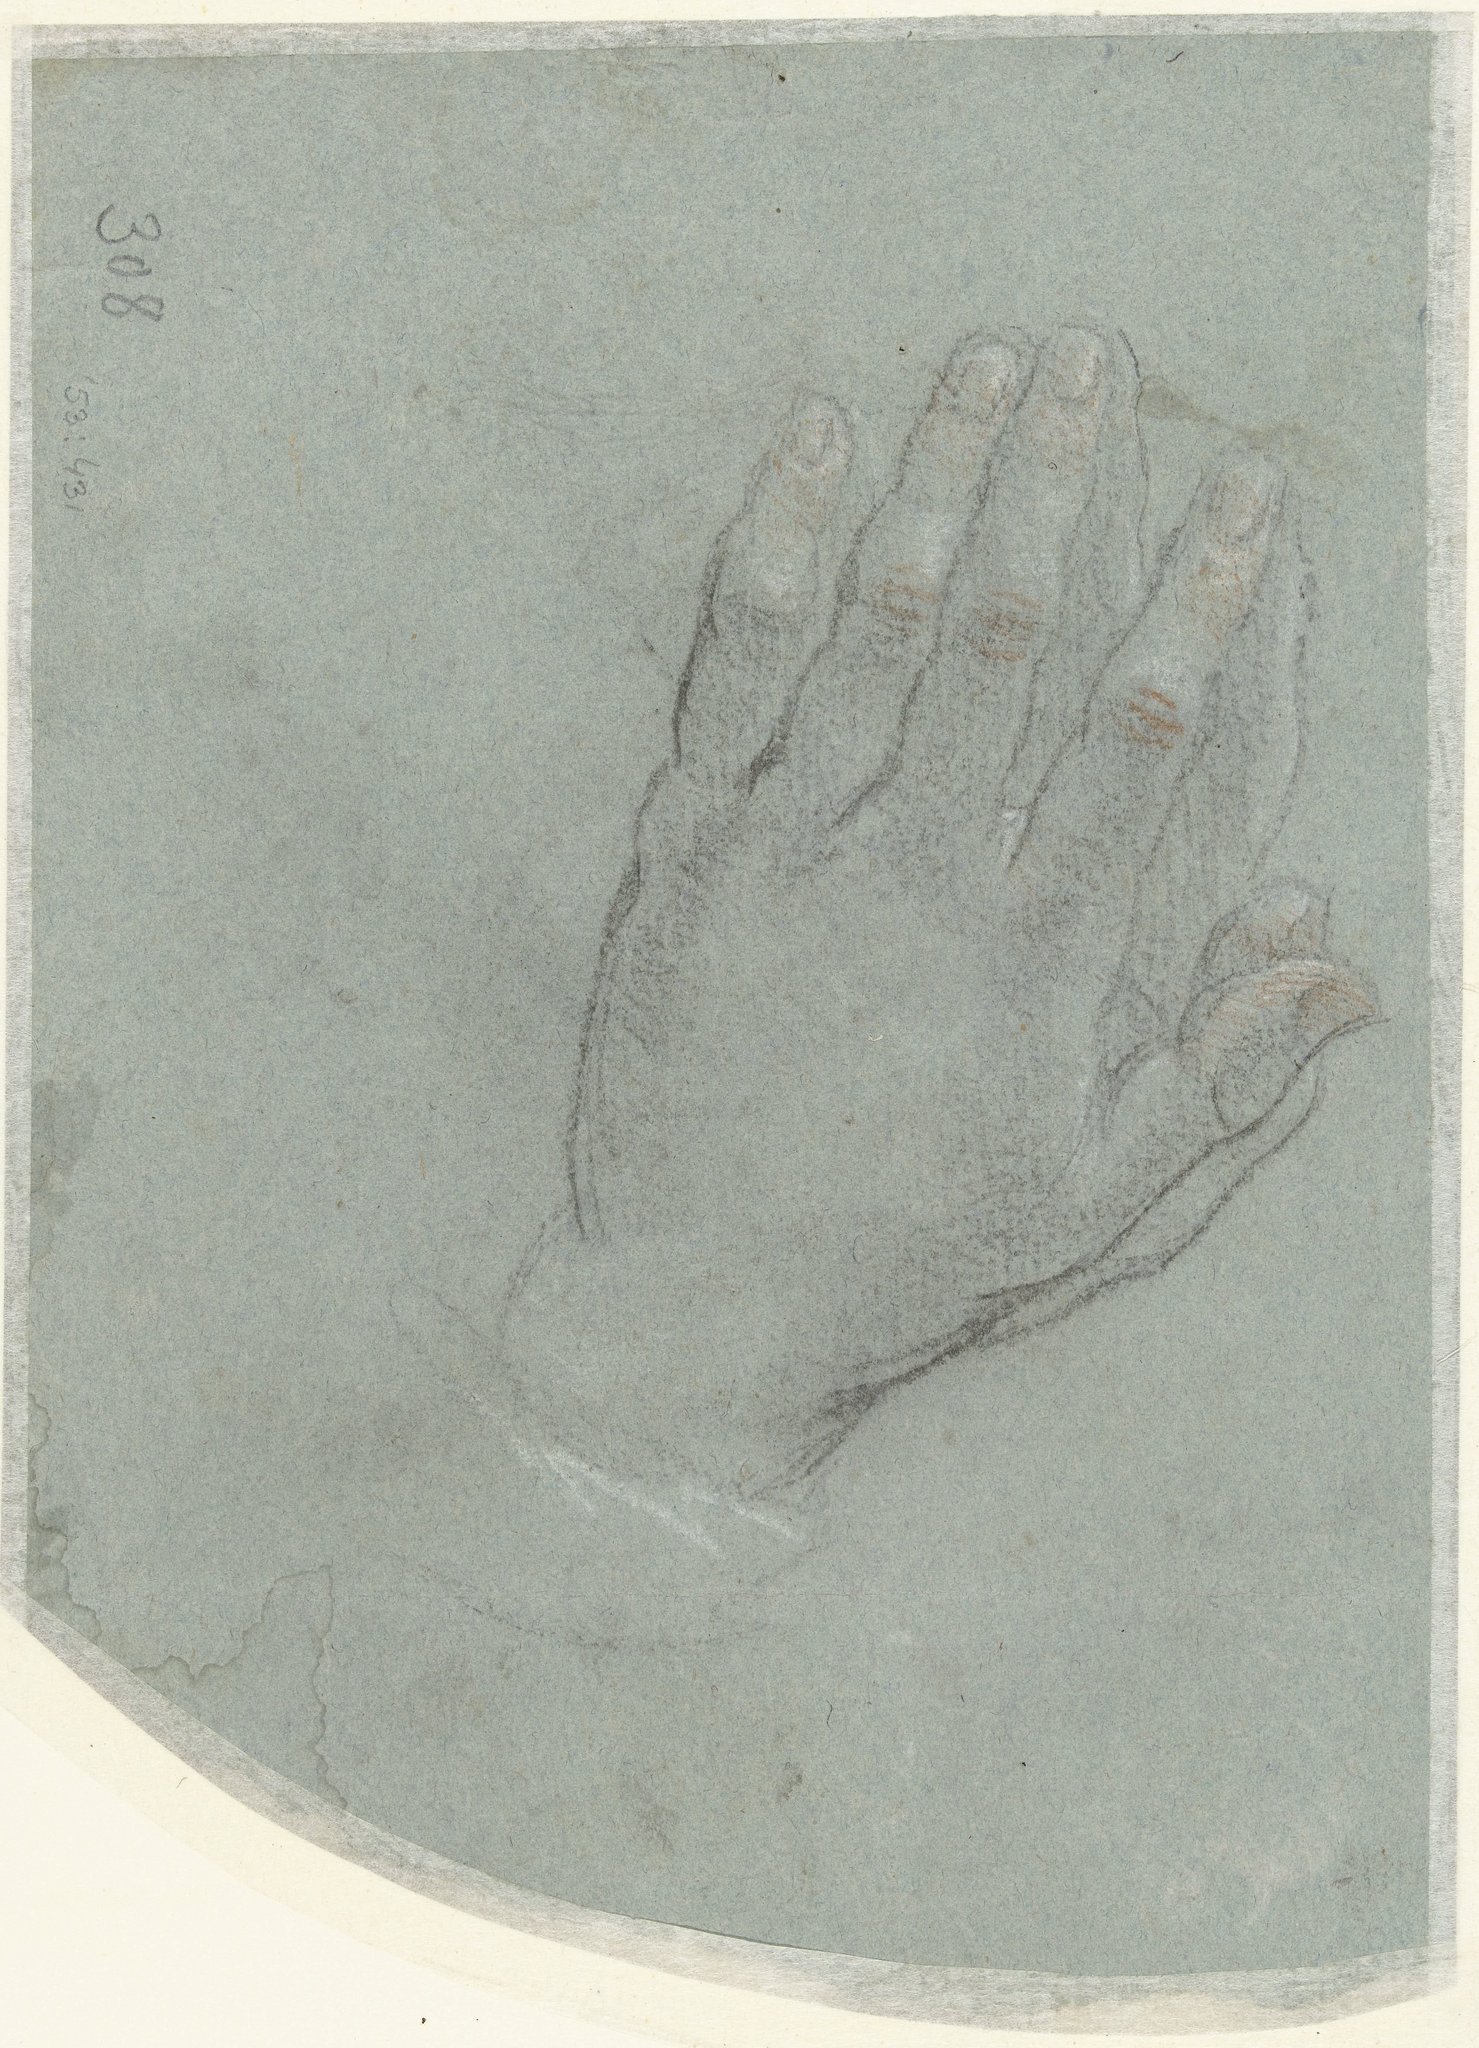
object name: drawing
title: Schetsbladen met figuurstudies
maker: Anonymous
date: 1610-1630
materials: chalk, paper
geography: verona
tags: hand